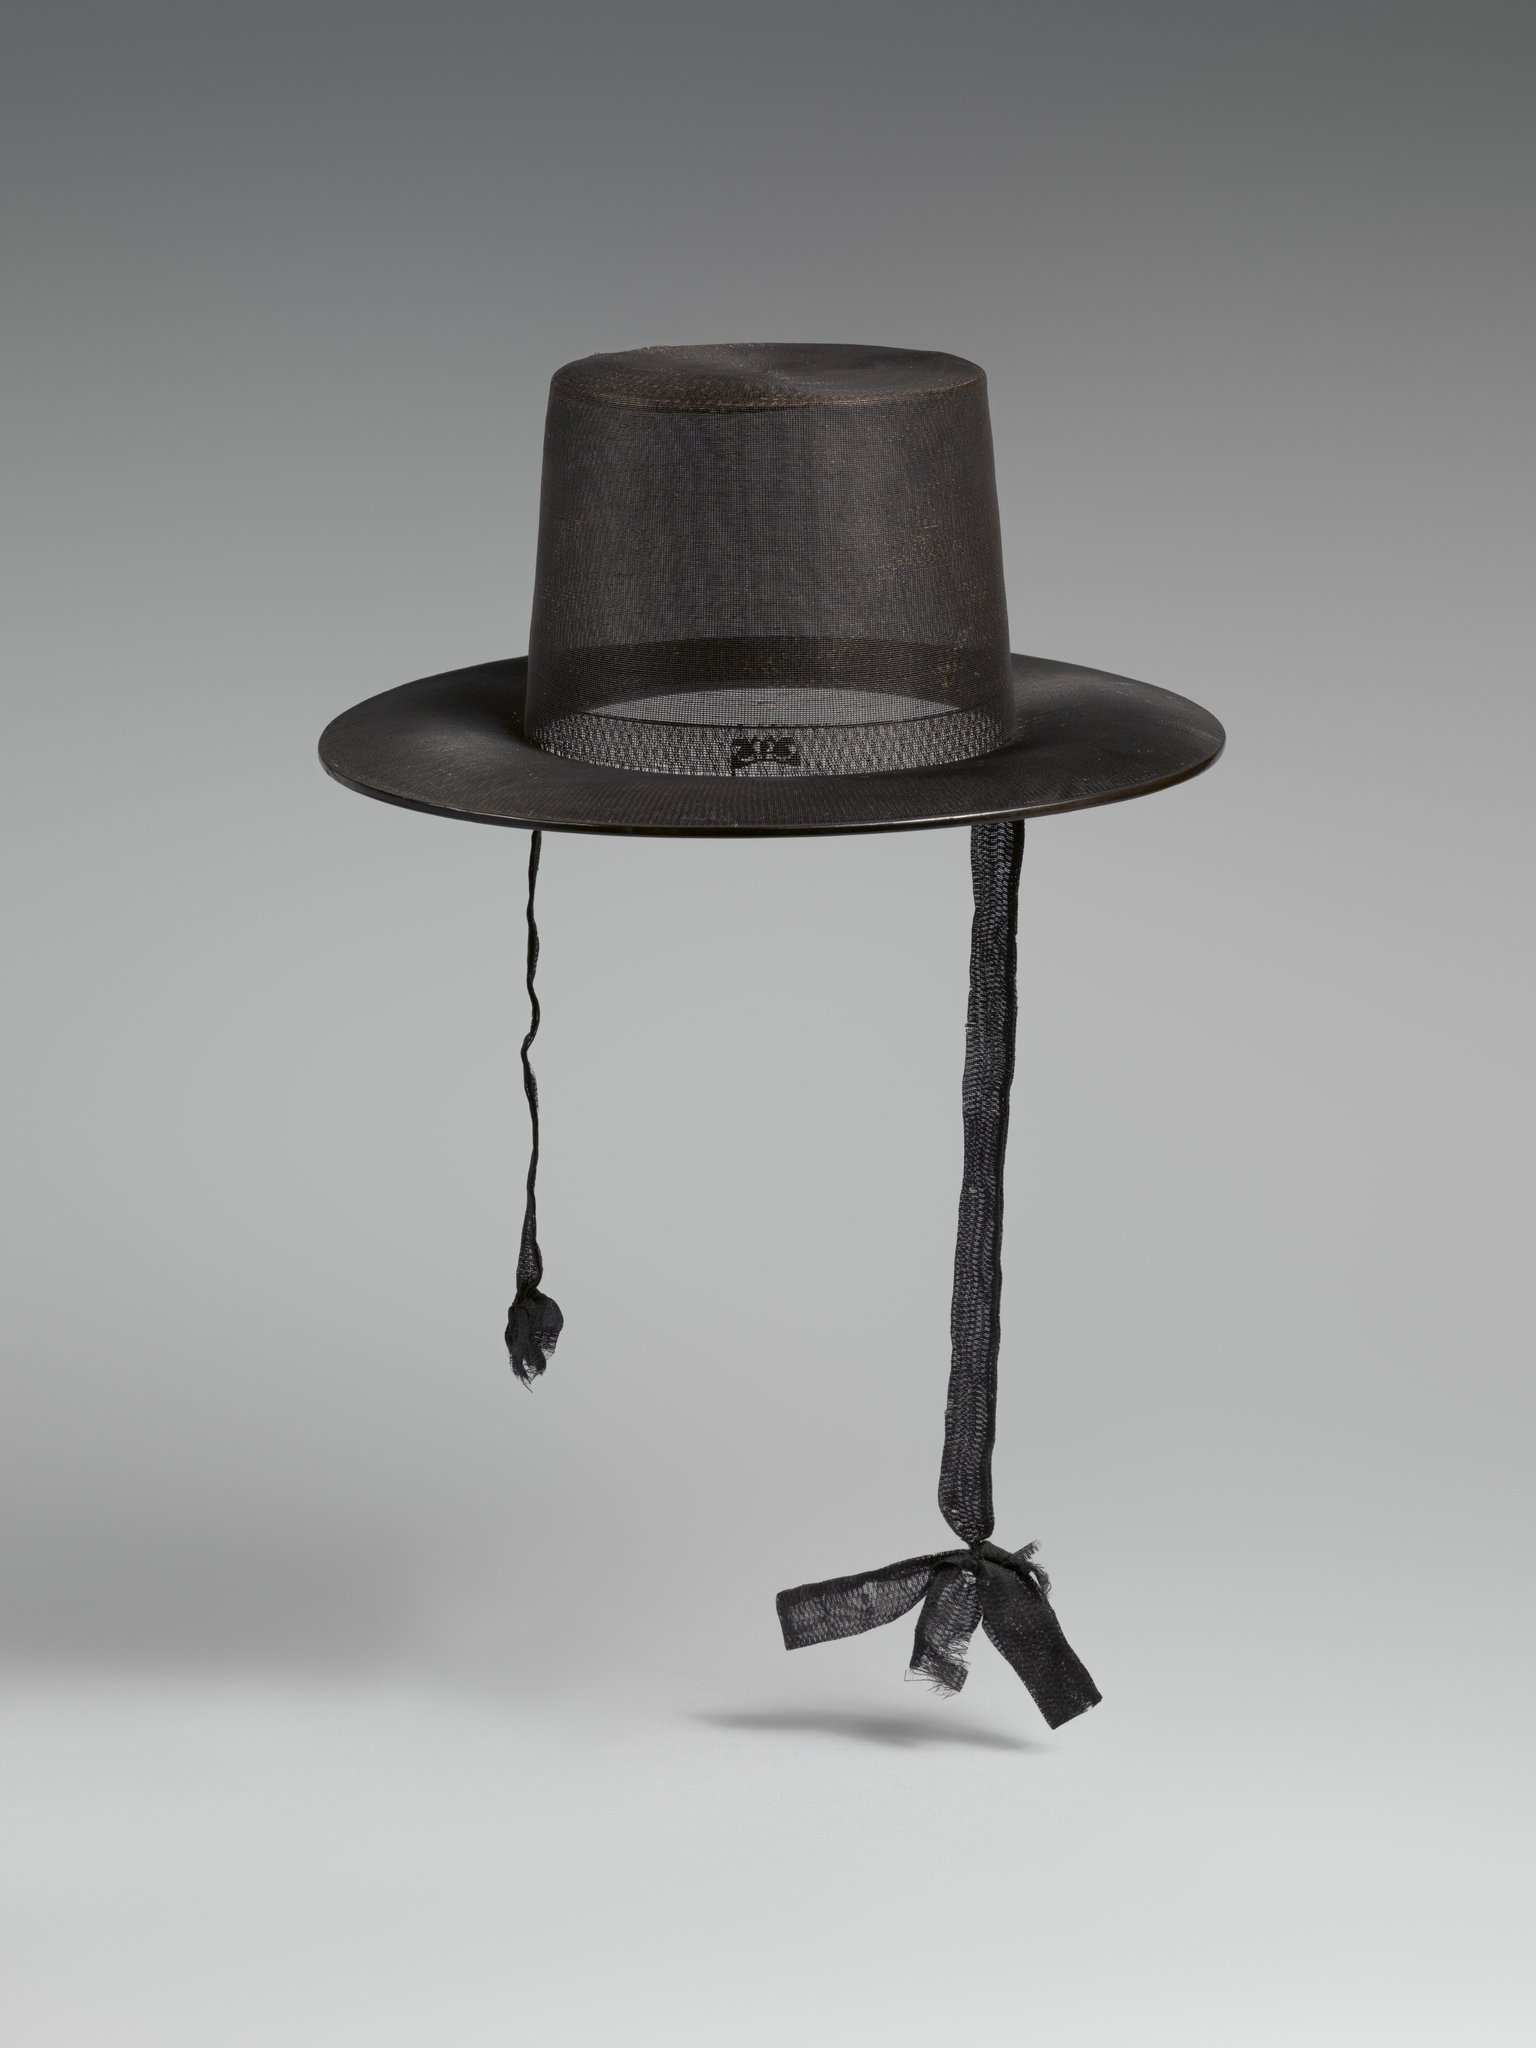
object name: man's hat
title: Man's hat (gat)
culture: korean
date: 1801-1900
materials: hair